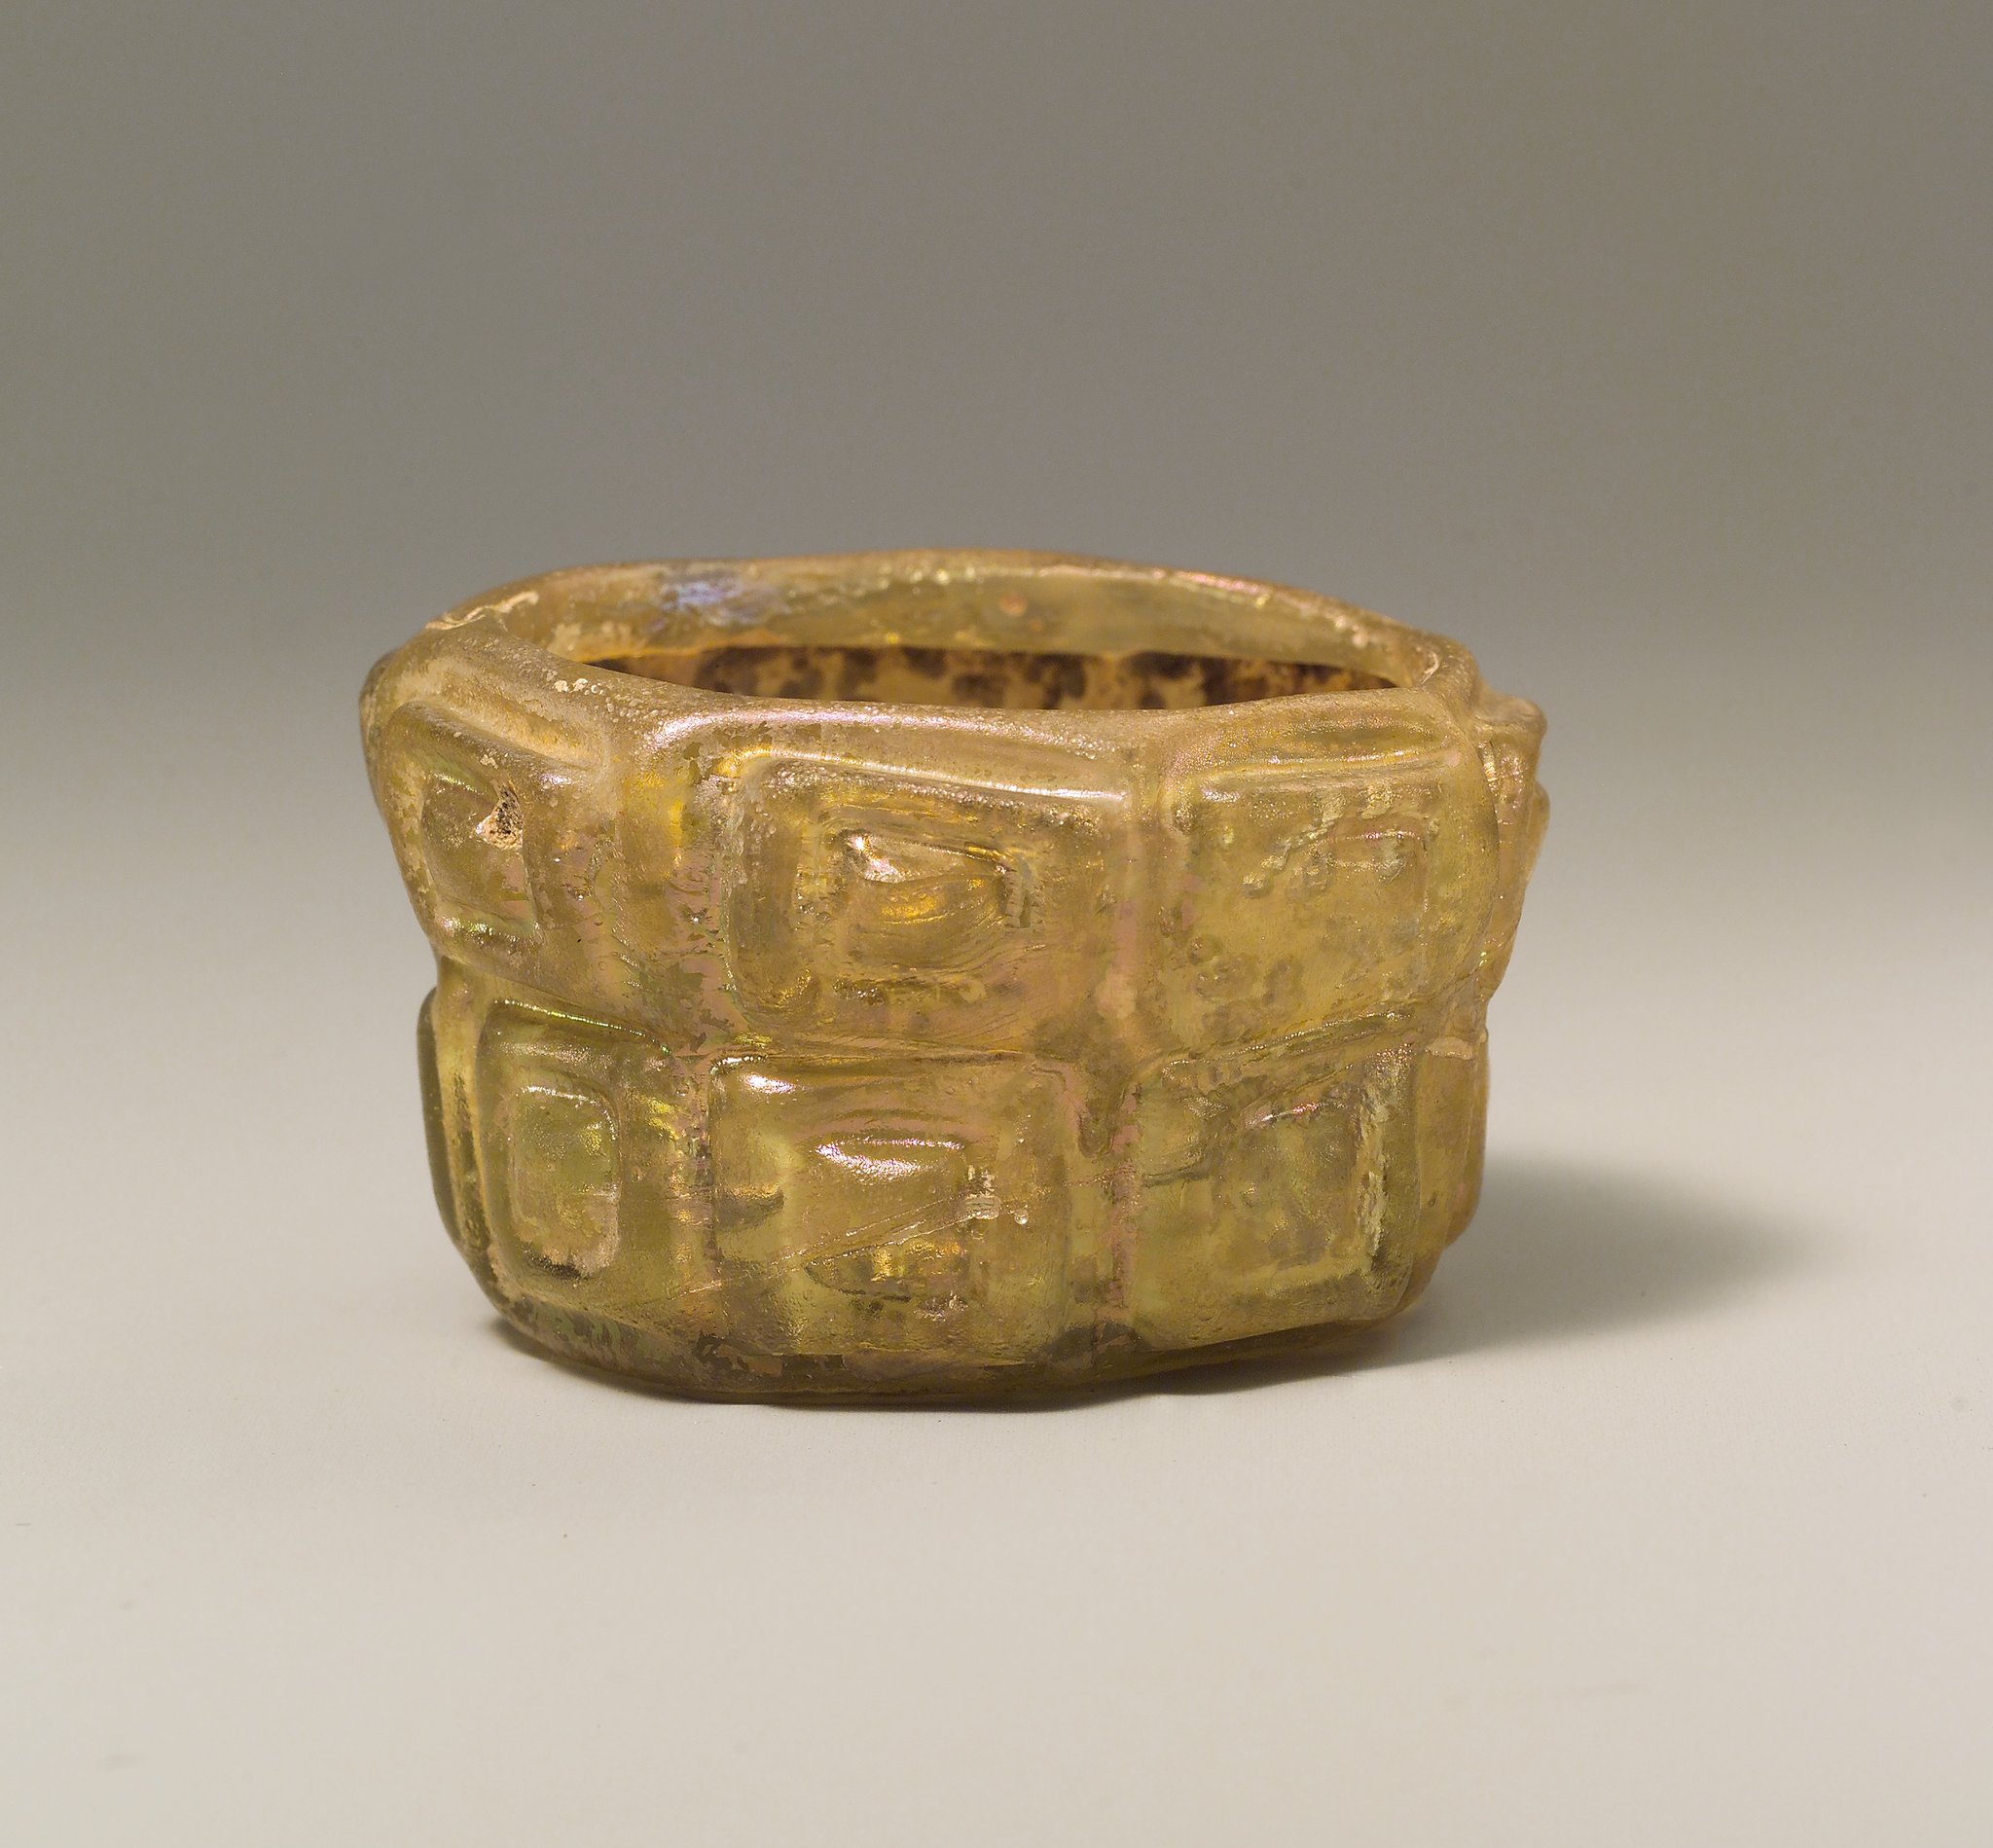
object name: cup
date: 801-1000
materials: glass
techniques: glassblowing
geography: egypt